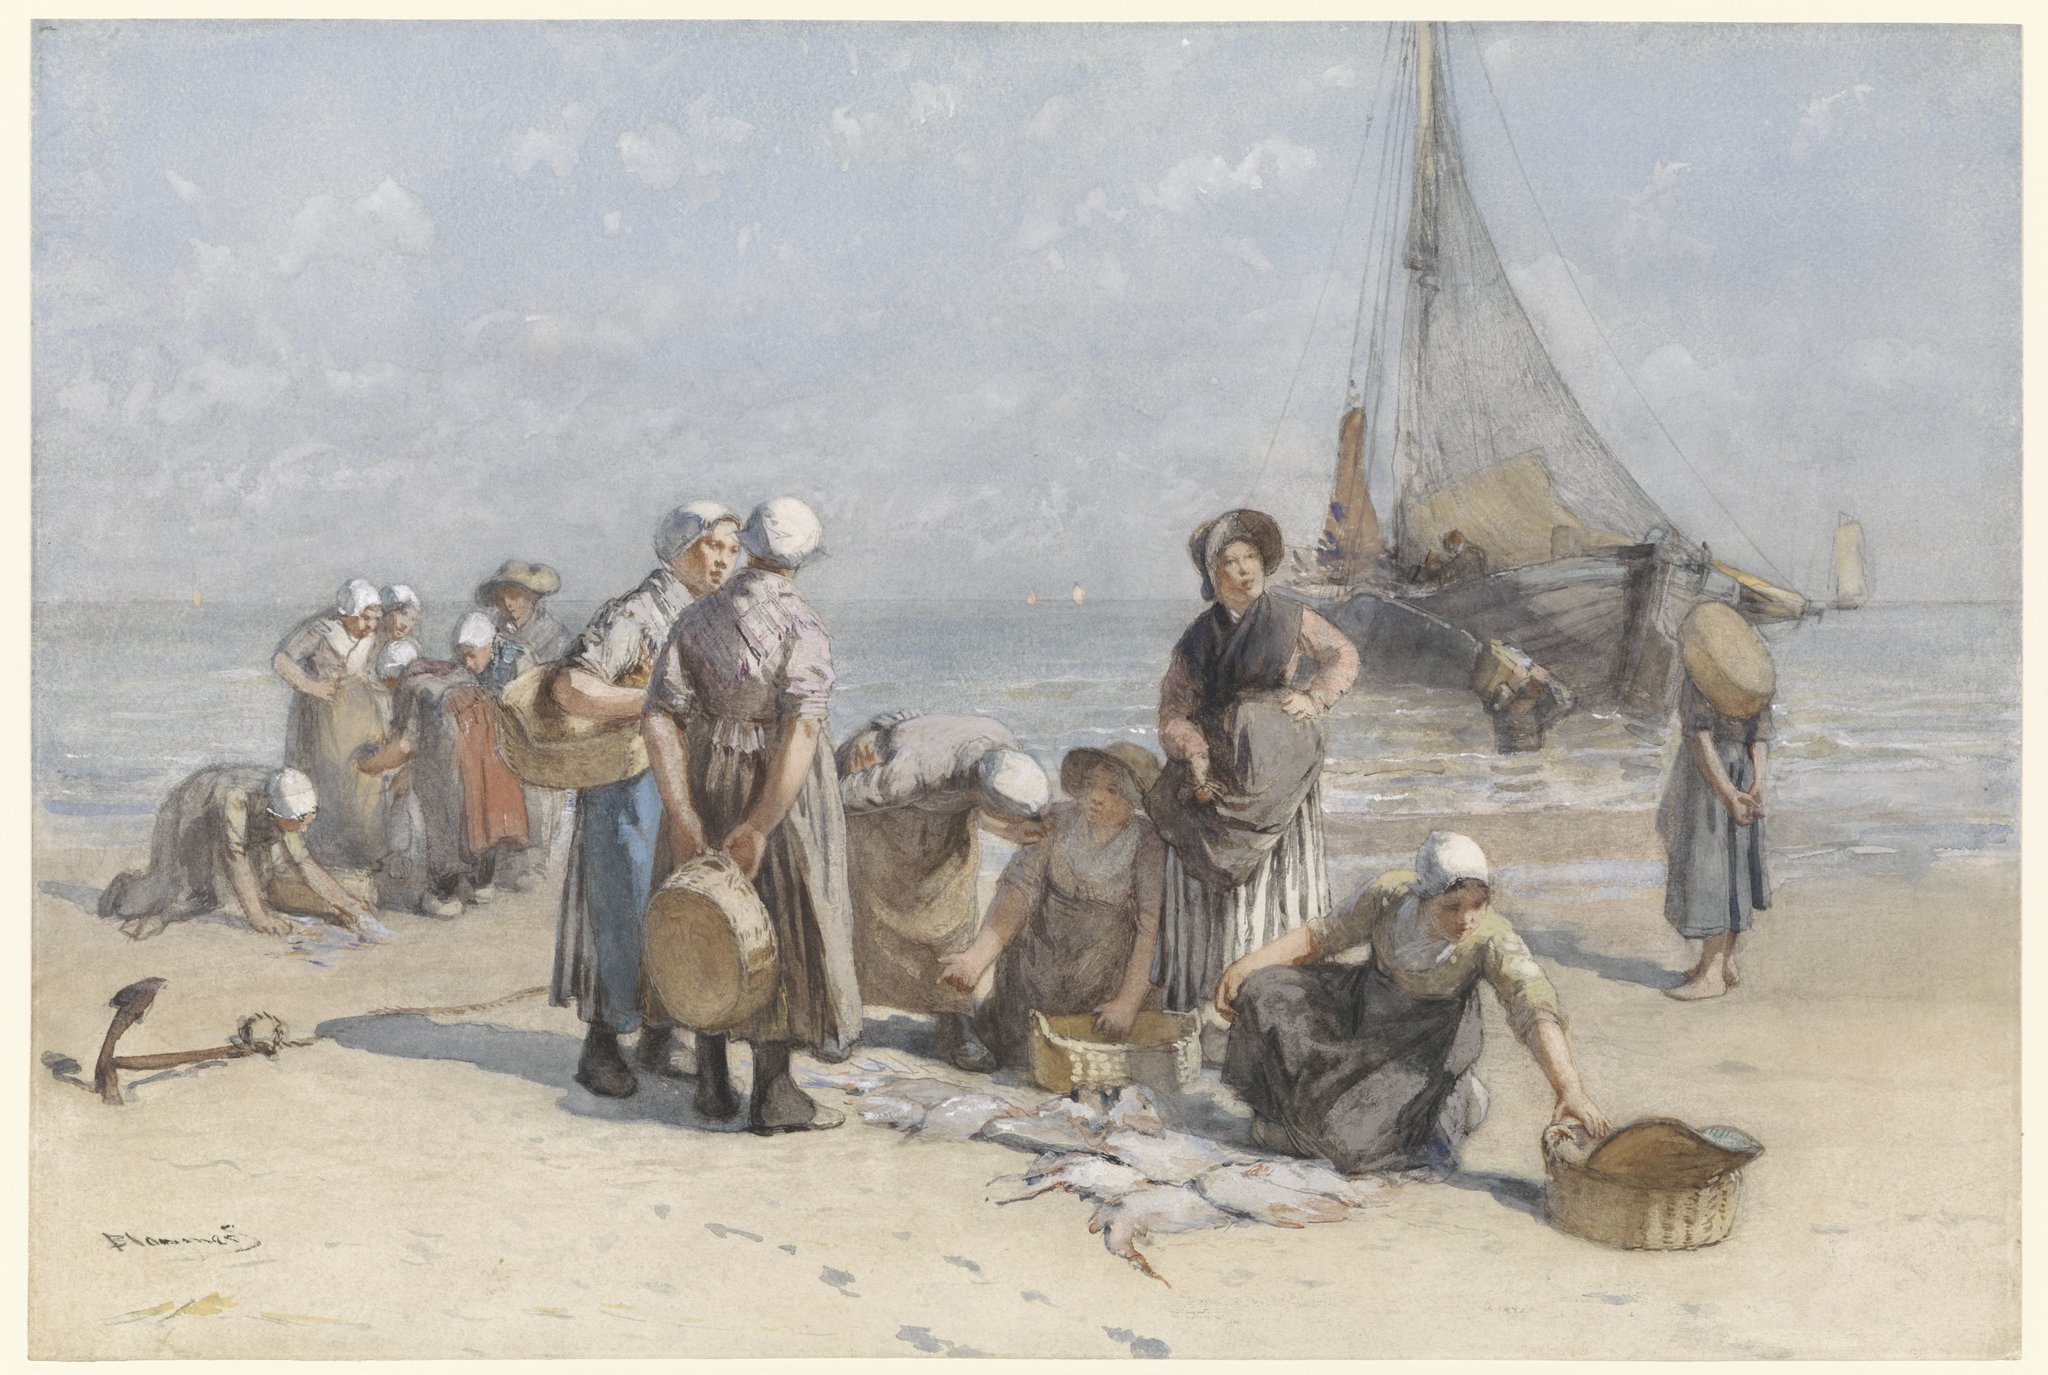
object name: watercolor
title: Fishwives on the Beach at Scheveningen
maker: bernardus johannes blommers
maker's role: draughtsman, print maker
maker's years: 1845-1914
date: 1880-1885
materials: chalk, paint, paper, pencil, watercolor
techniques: brush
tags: commercial fishery, persons engaged in trade and commerce - bb - women engaged in trade and commerce, fish; still life of fishes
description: The small, square-rigged bomschuits brought their catch onto the beach at Scheveningen to be sorted and auctioned. Fishwives filled their large baskets with fresh fish for sale in the town. This watercolour is not from the Drucker-Fraser collection, but from a legacy left by Jhr. P.A. van den Velden in 1892. He laid the ground for the Rijksmuseum’s collection of 19th-century drawings and watercolours.